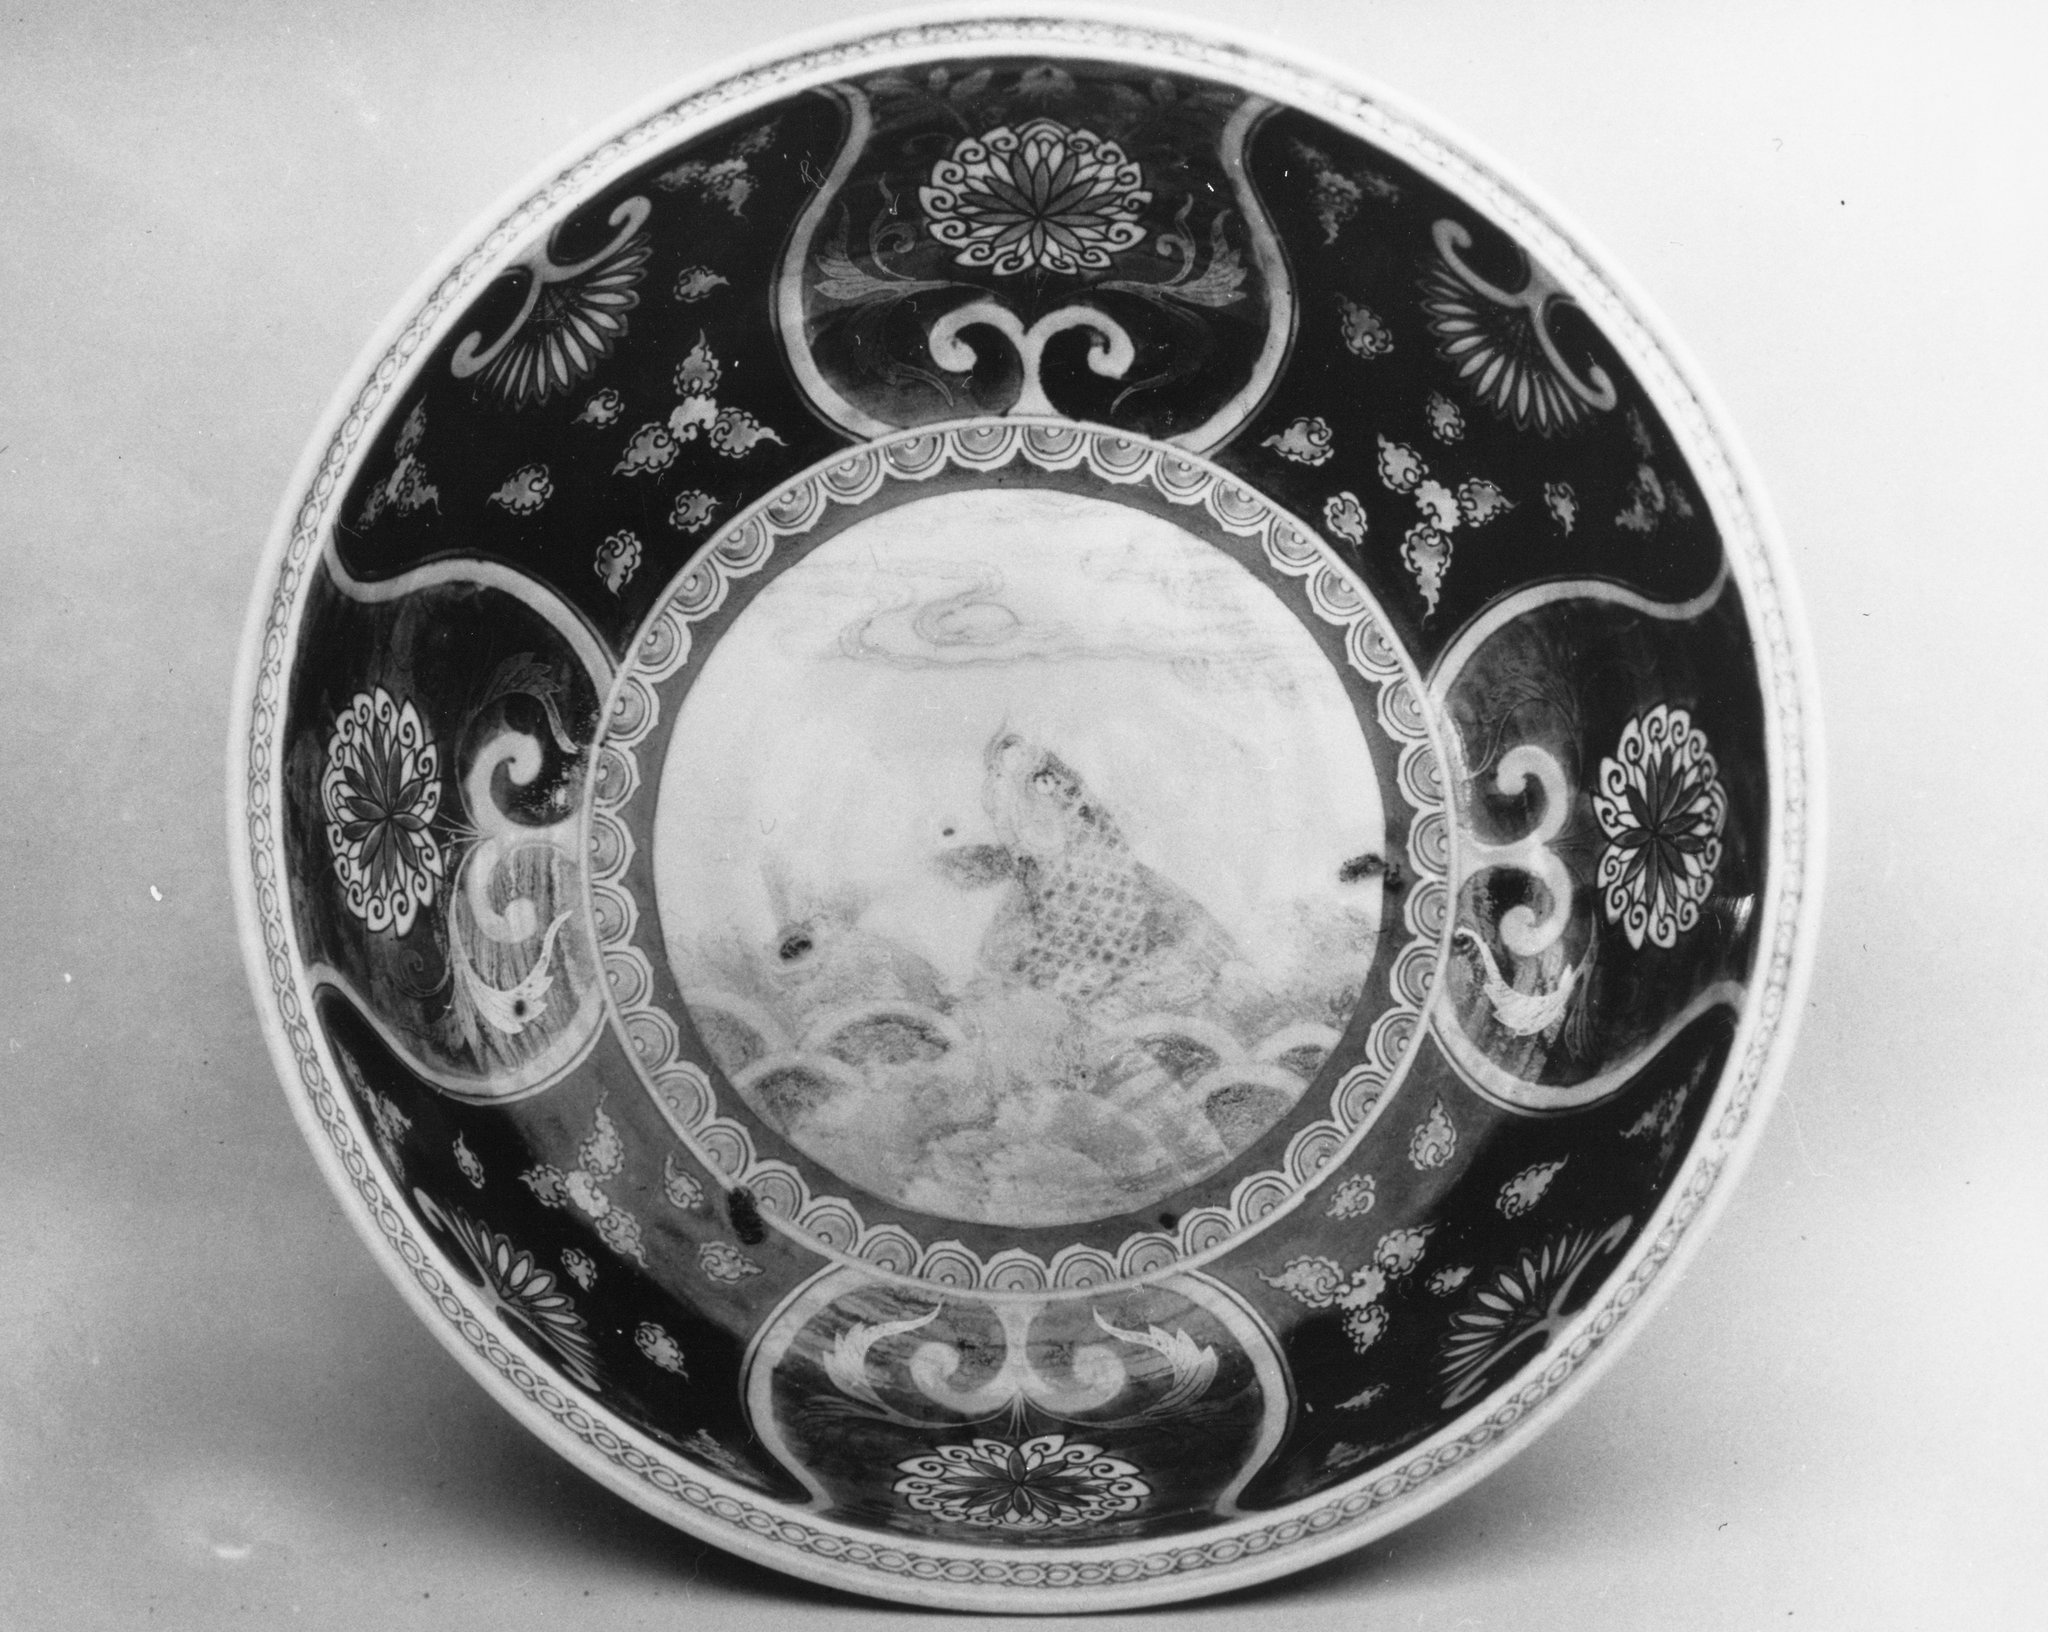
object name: dish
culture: japanese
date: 1760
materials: enamel, glaze, porcelain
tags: flowers